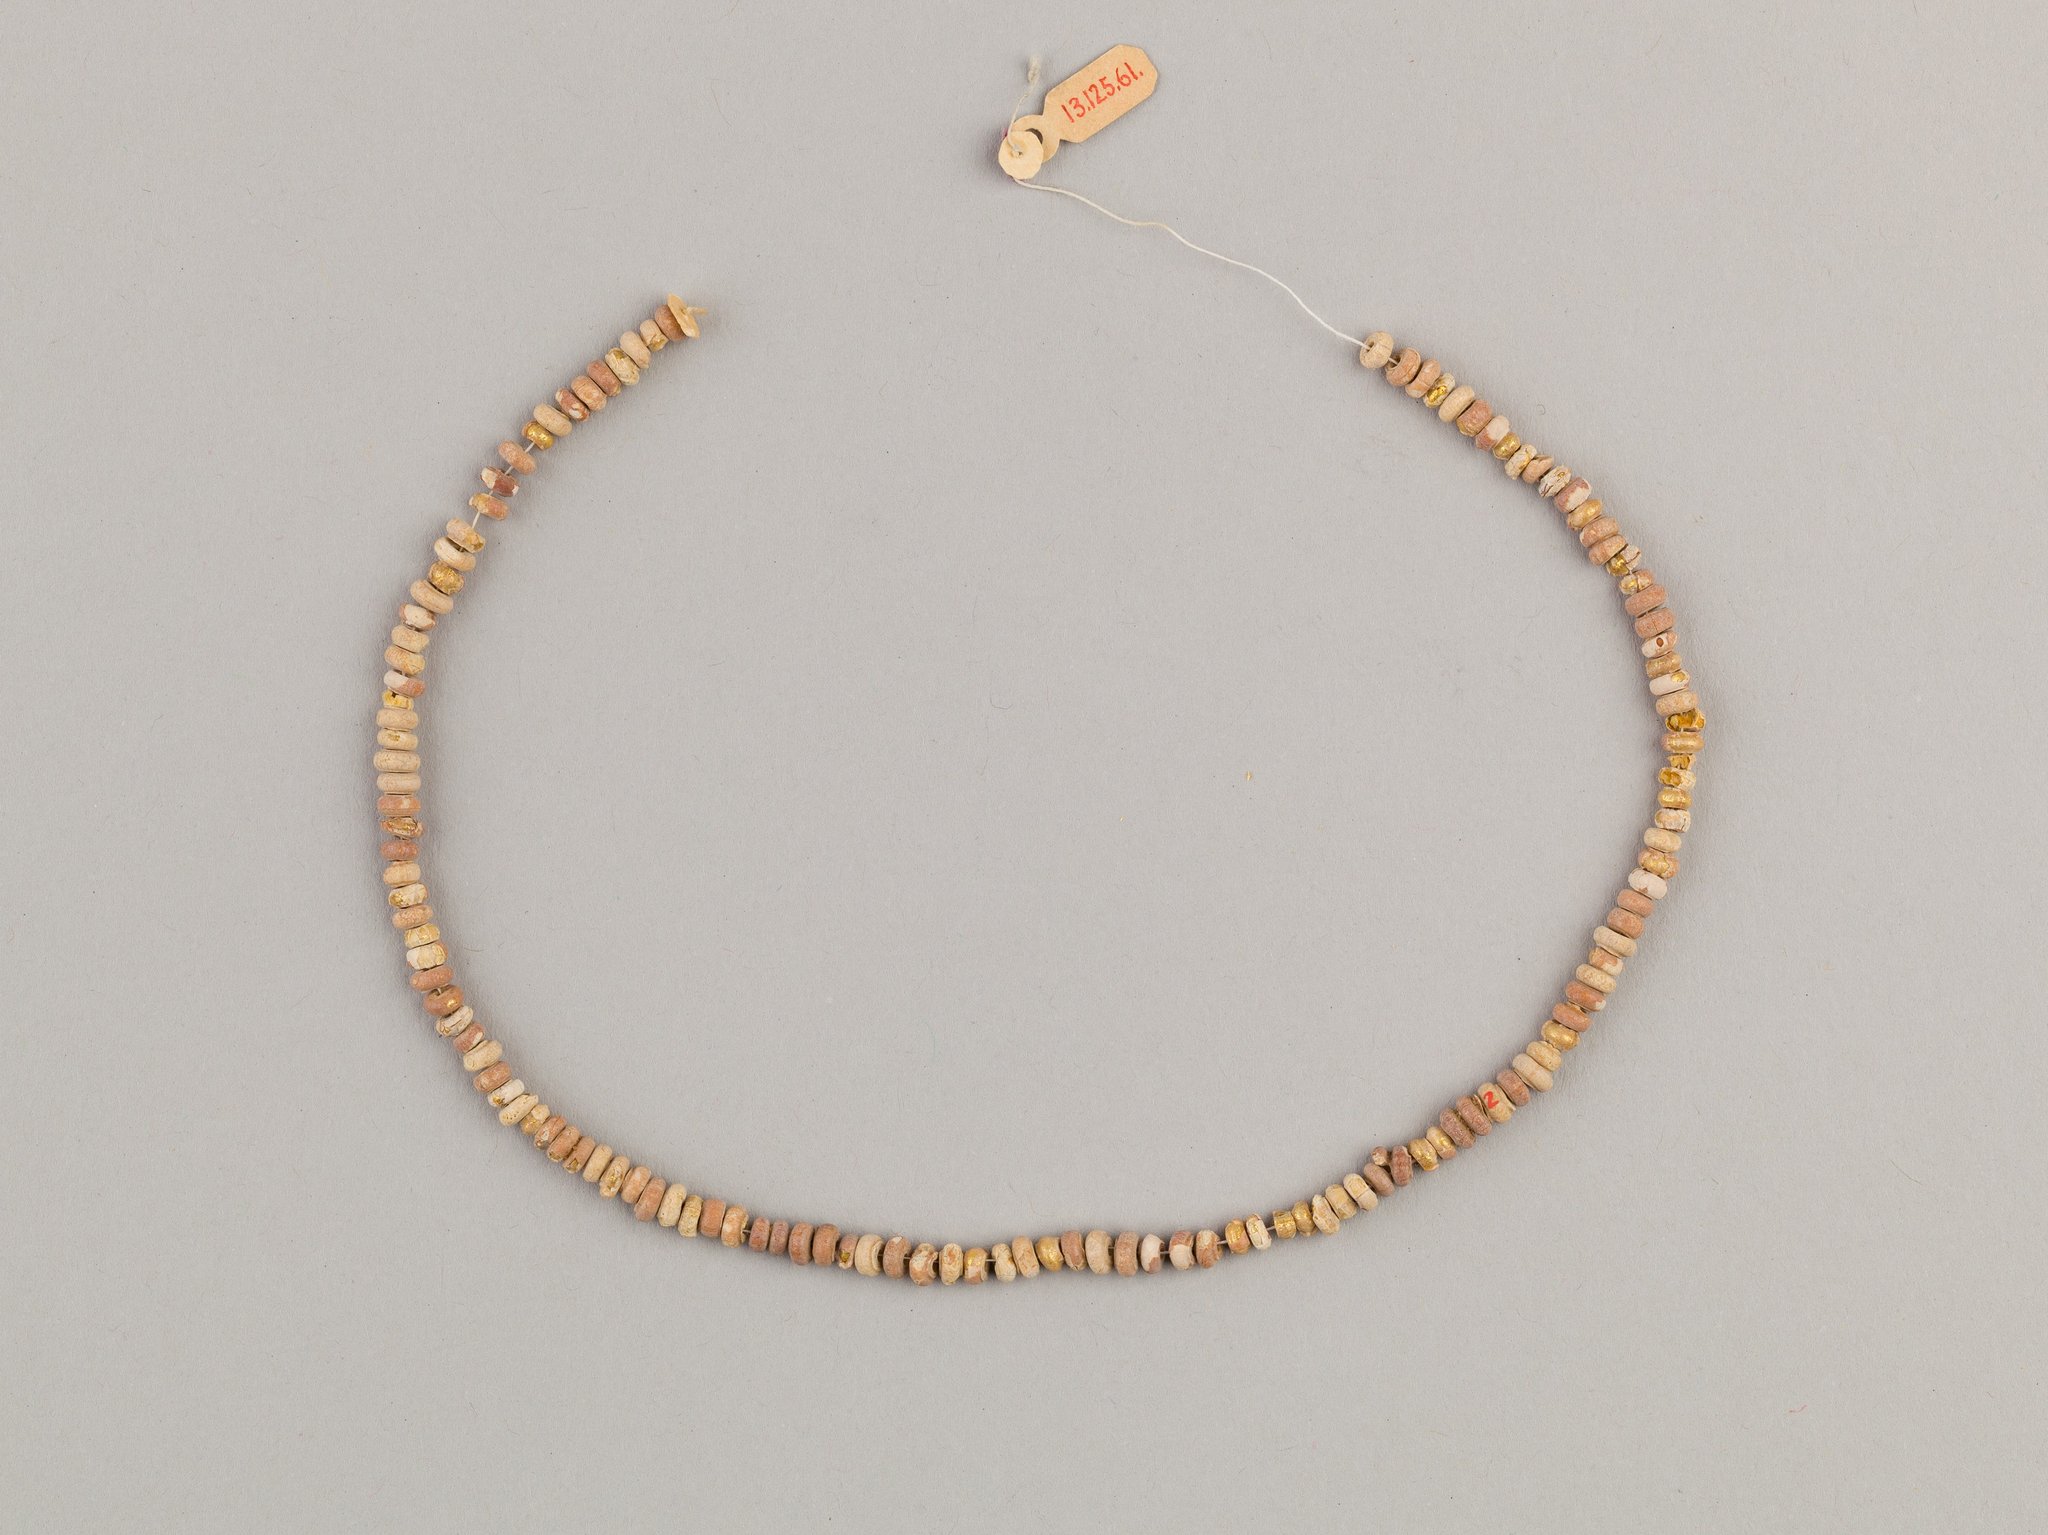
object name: bead, string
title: String of beads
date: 30 BCE-364 CE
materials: faience, gilt, glass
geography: nubia